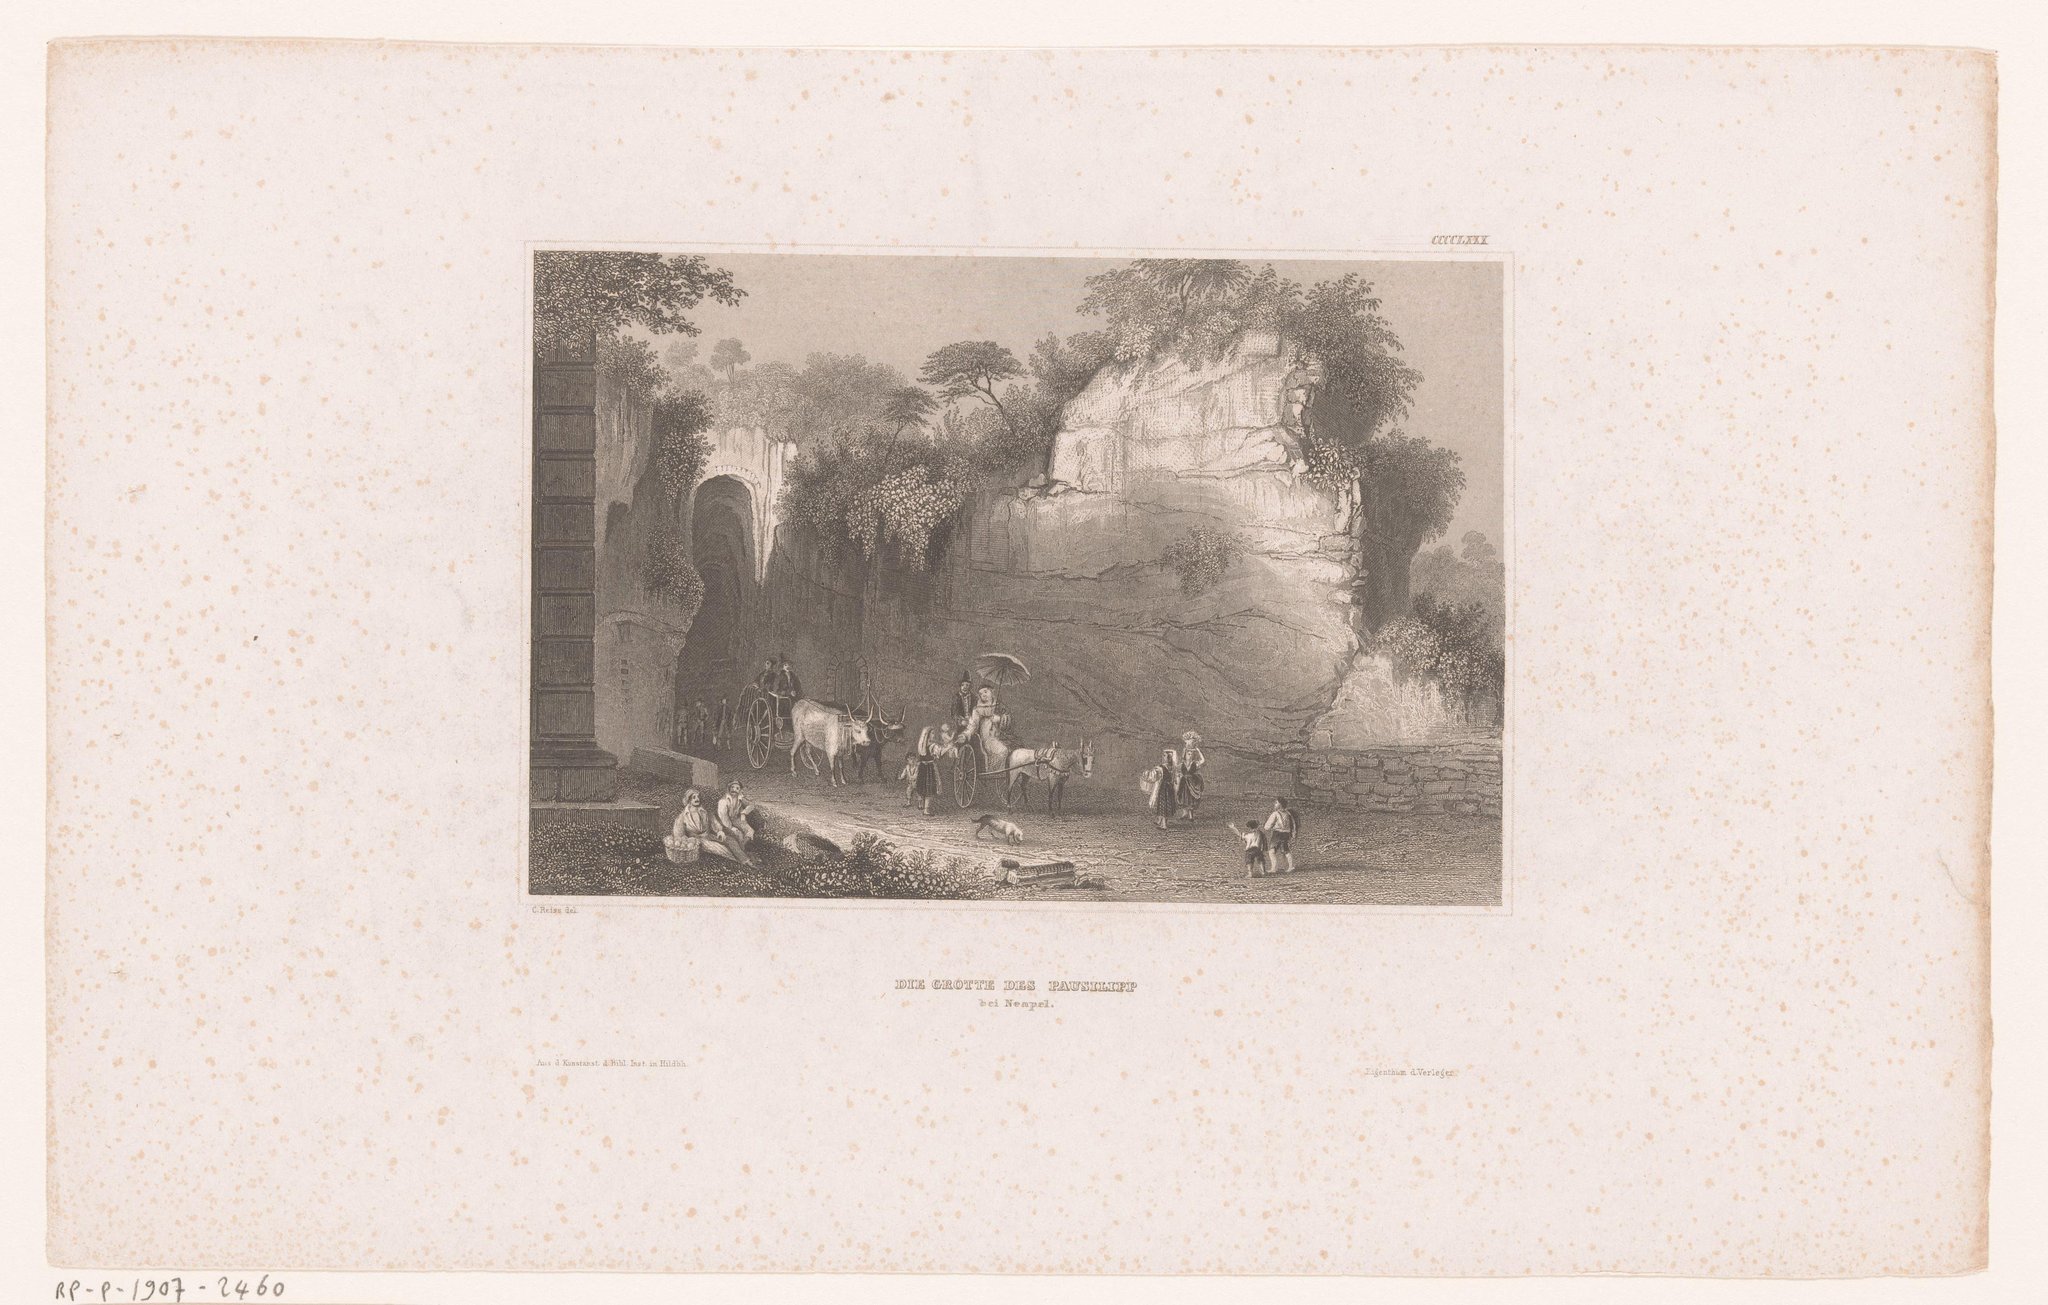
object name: print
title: Die Grotte des pausilipp bei Neapel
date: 1800-1899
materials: paper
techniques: engraving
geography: germany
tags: city-view, and landscape with man-made constructions, cave, grotto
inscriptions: collector's mark: Lugt 2228